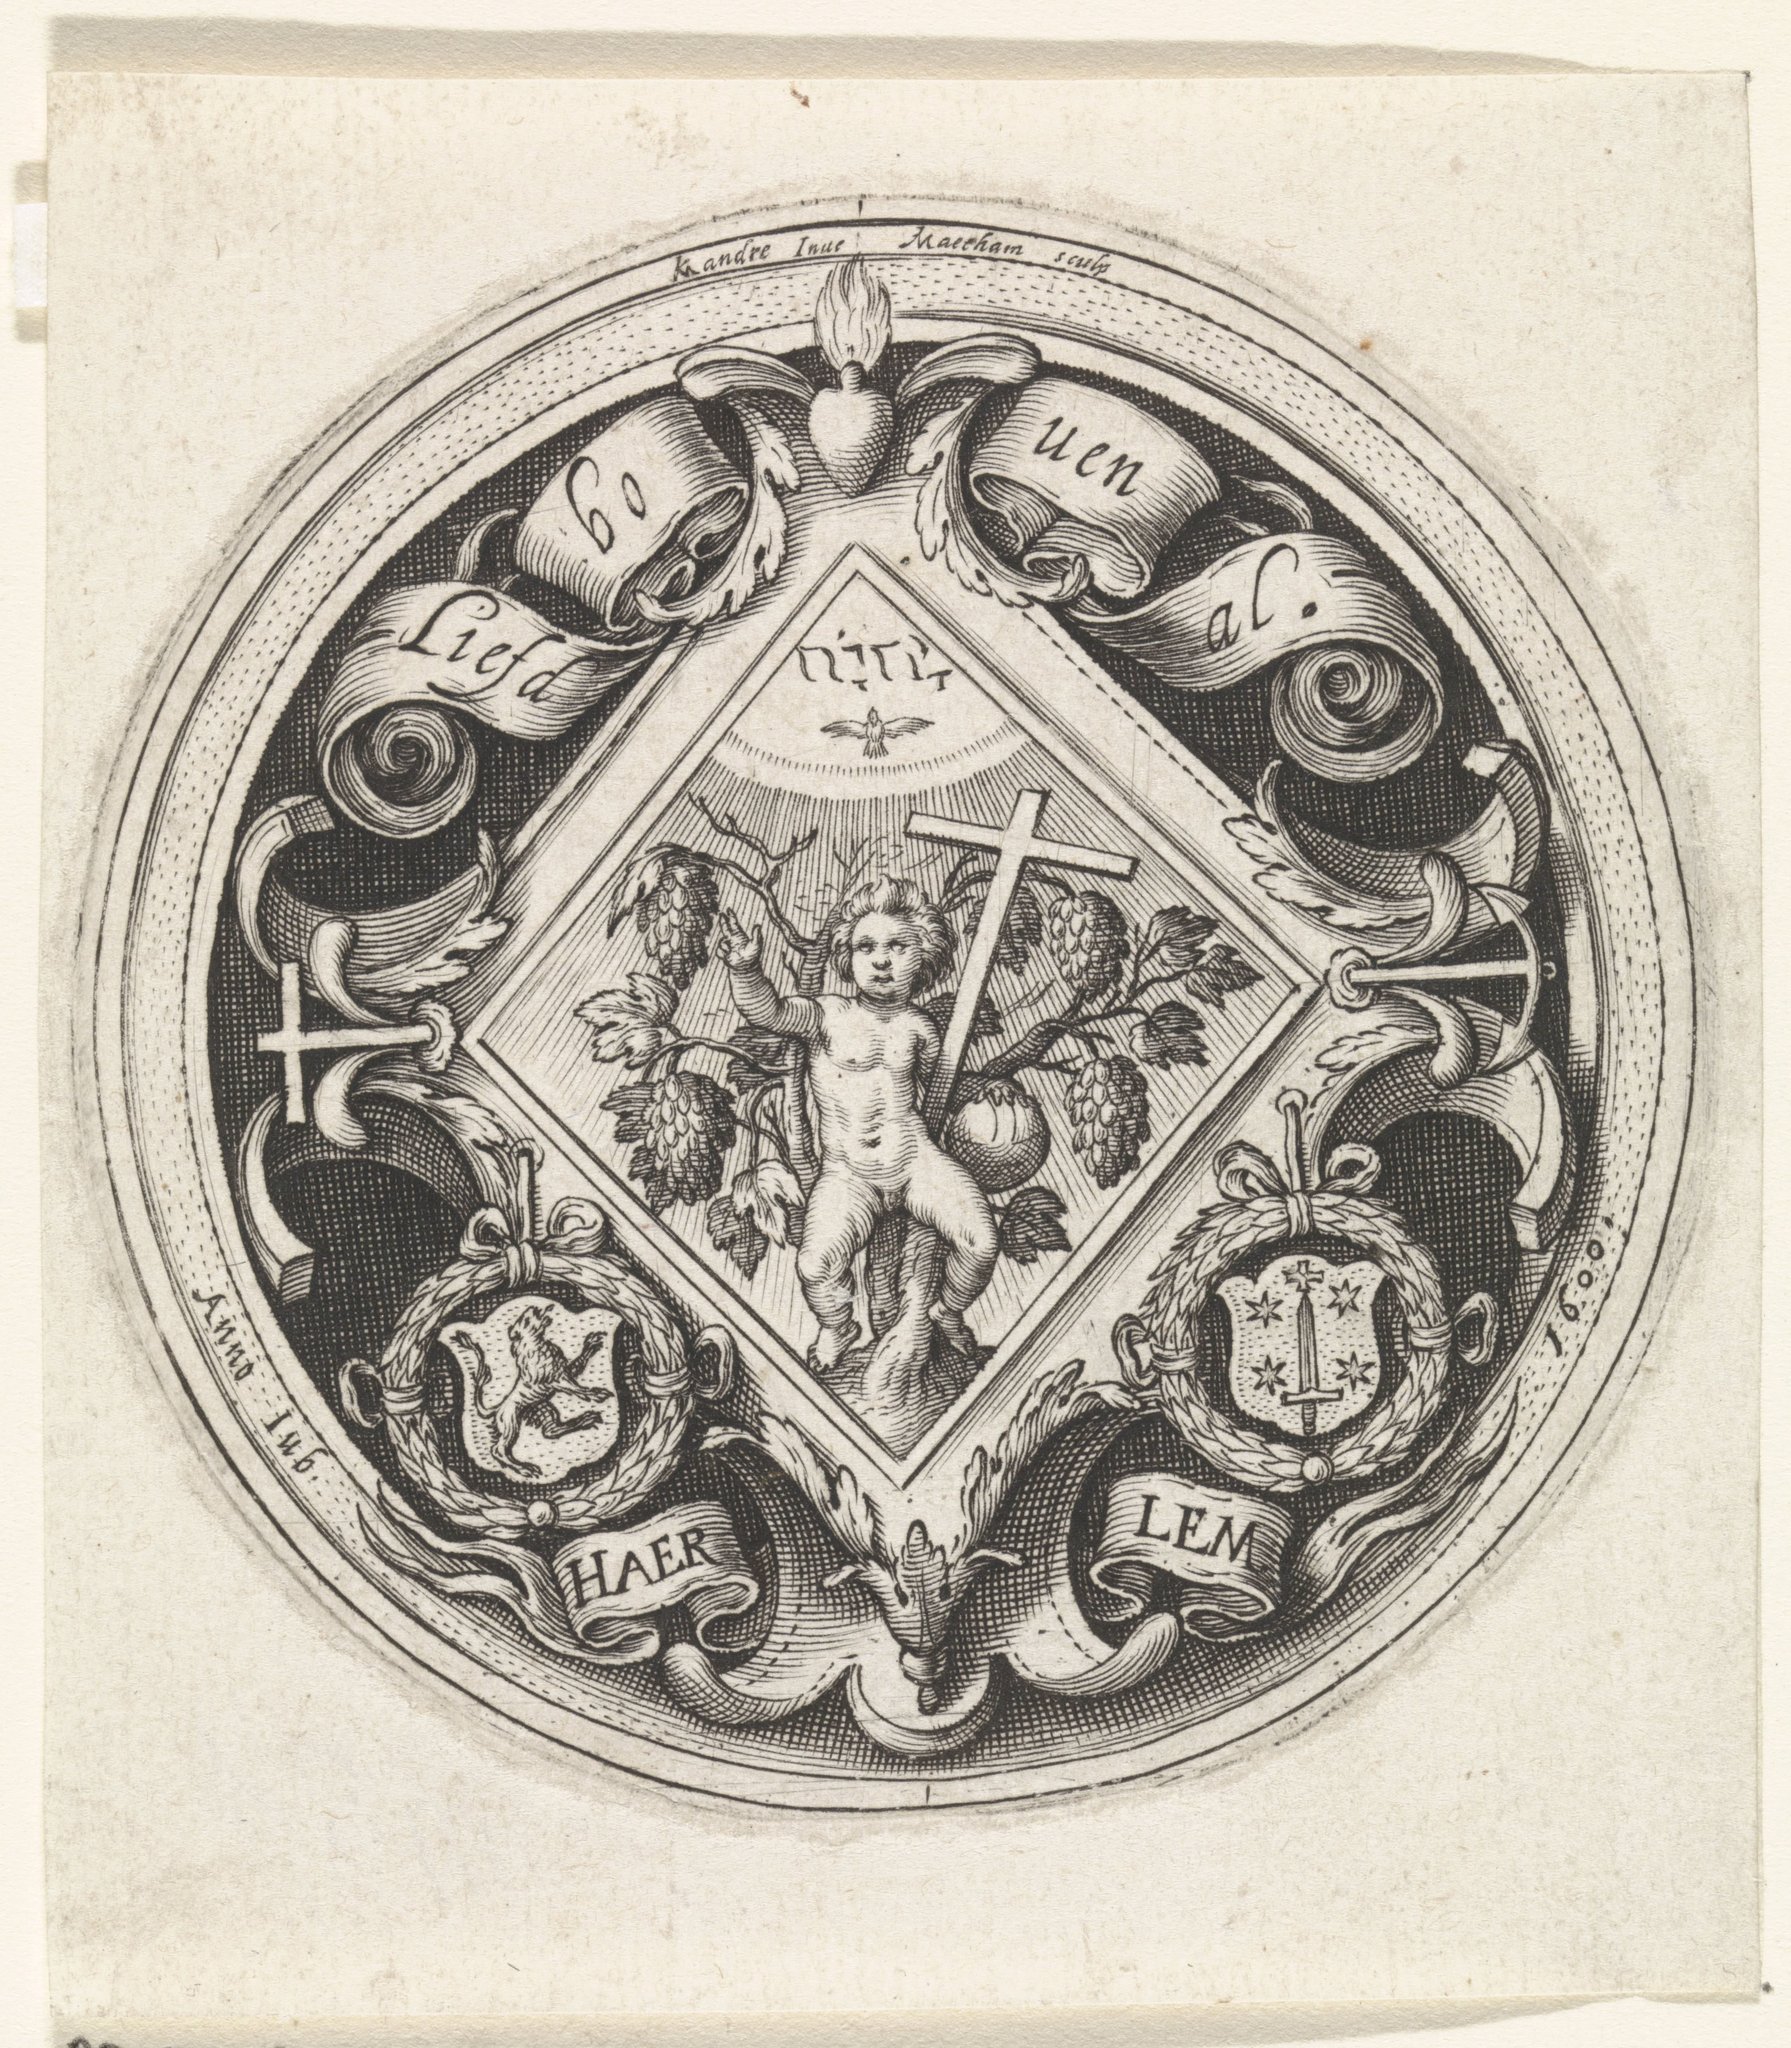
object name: print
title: Blazoen van de Haarlemse rederijkerskamer De Wijngaertrancken, 1600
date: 1600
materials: paper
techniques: engraving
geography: haarlem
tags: chamber of rhetoric (dutch: 'rederijkerskamer'), armorial bearing, heraldry, haarlem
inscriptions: date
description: Blazoen van de Haarlemse rederijkerskamer De Wijngaertrancken, 1600. Ruitvormige voorstelling van het Christuskind met kruis op een wijnrank. Hieromheen banderollen met het devies: Liefde boven al en de plaatsnaam Haerlem. Met de wapens van Holland en Haarlem.